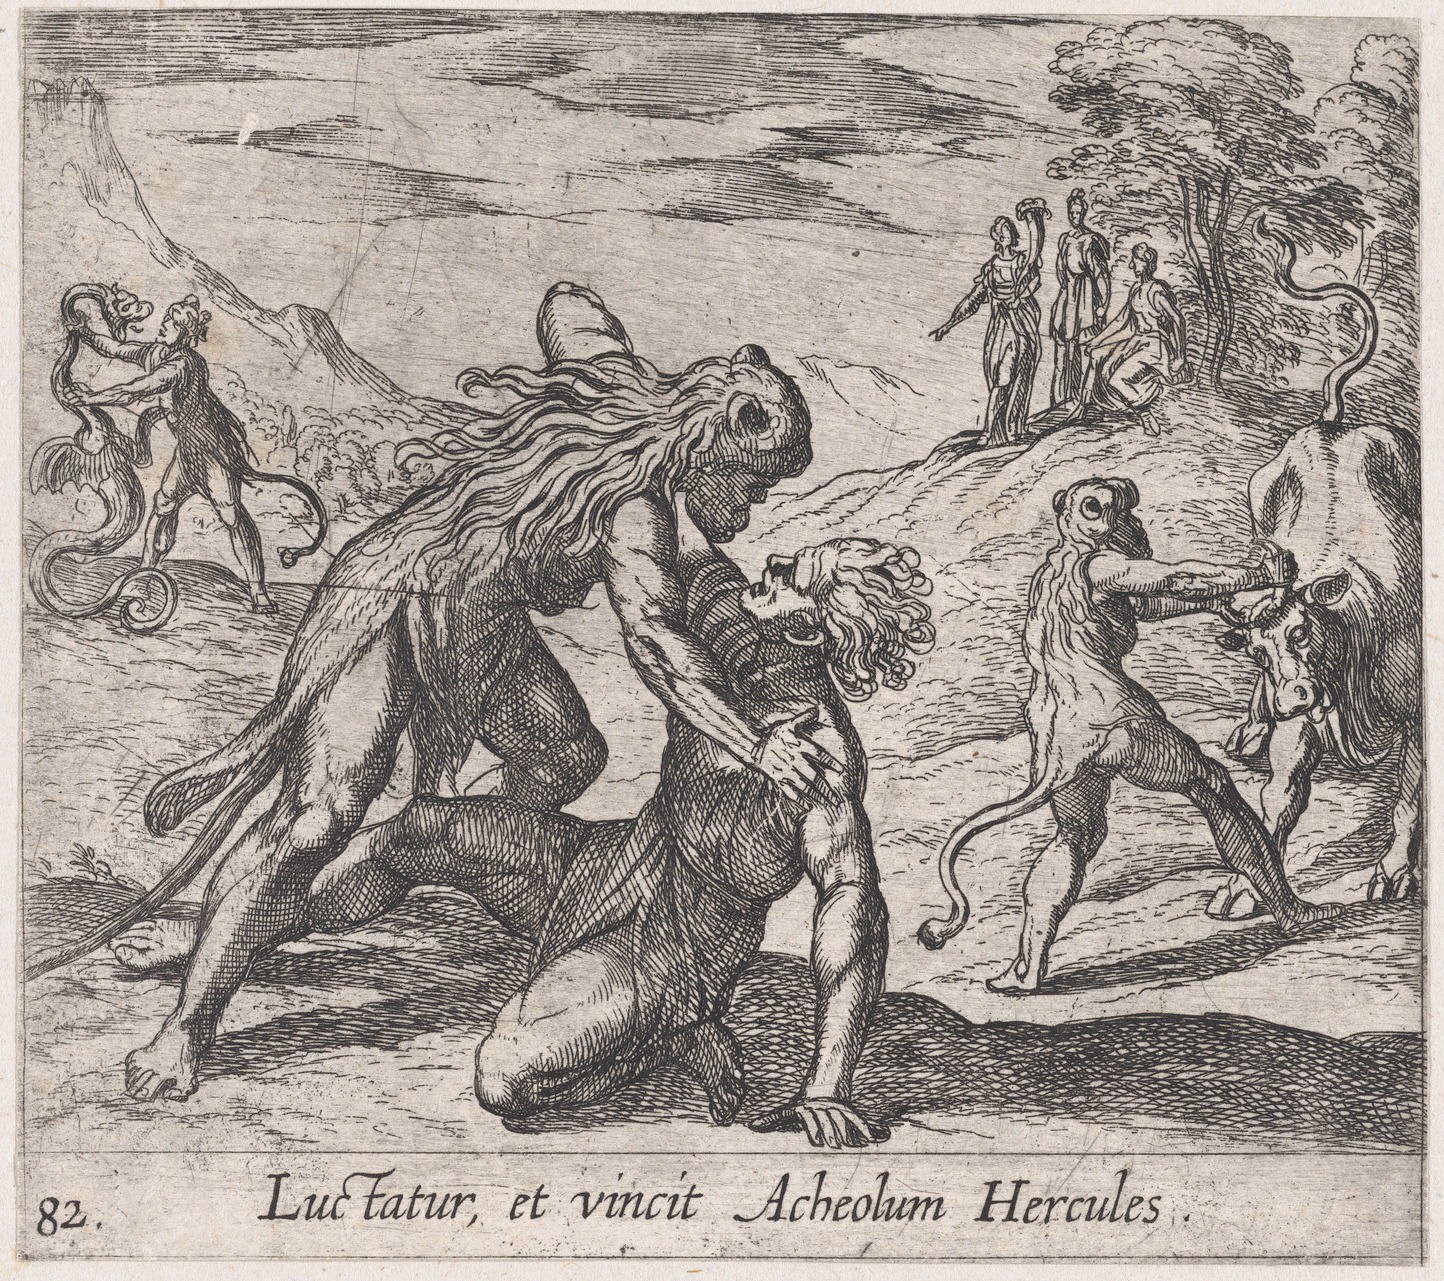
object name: print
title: Plate 82: Hercules and Acheloüs (Luctatur, et vincit Acheolum Hercules), from Ovid's 'Metamorphoses'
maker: antonio tempesta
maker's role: artist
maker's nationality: italian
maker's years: 1555-1630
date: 1606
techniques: etching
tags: men,hercules,bulls